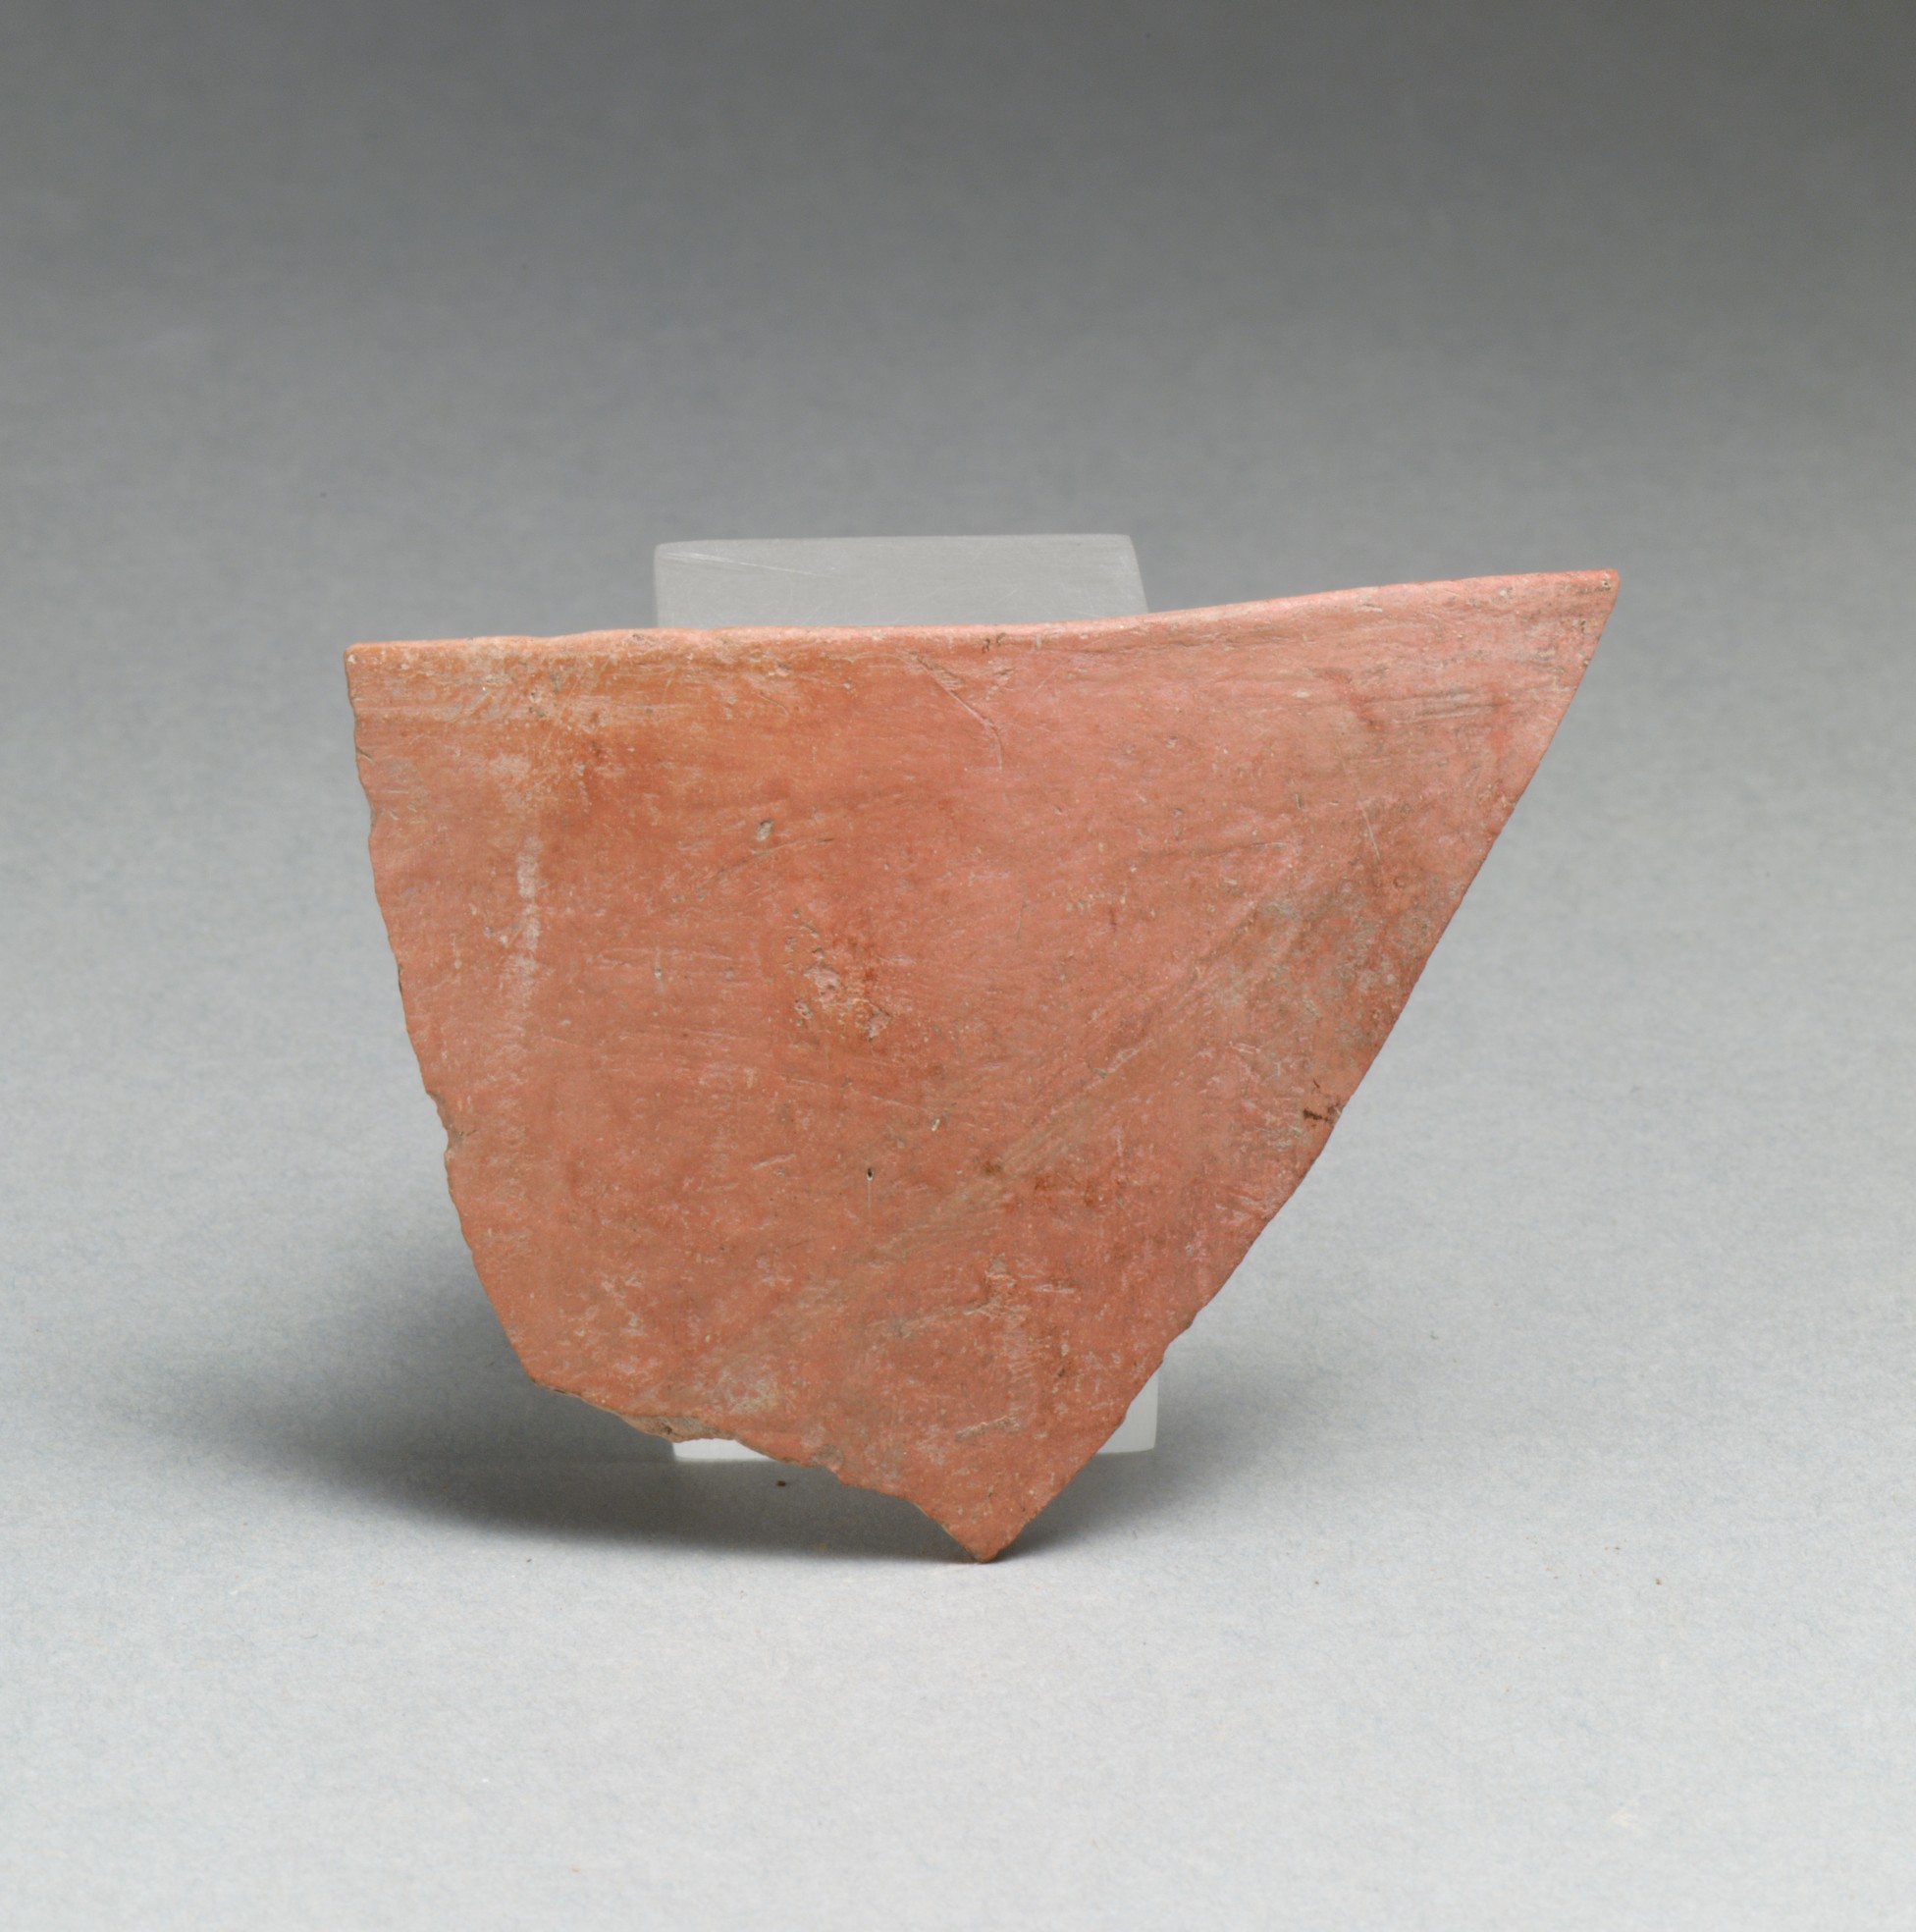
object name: vase fragment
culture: neolithic, thessaly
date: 6500-5800 BCE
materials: terracotta